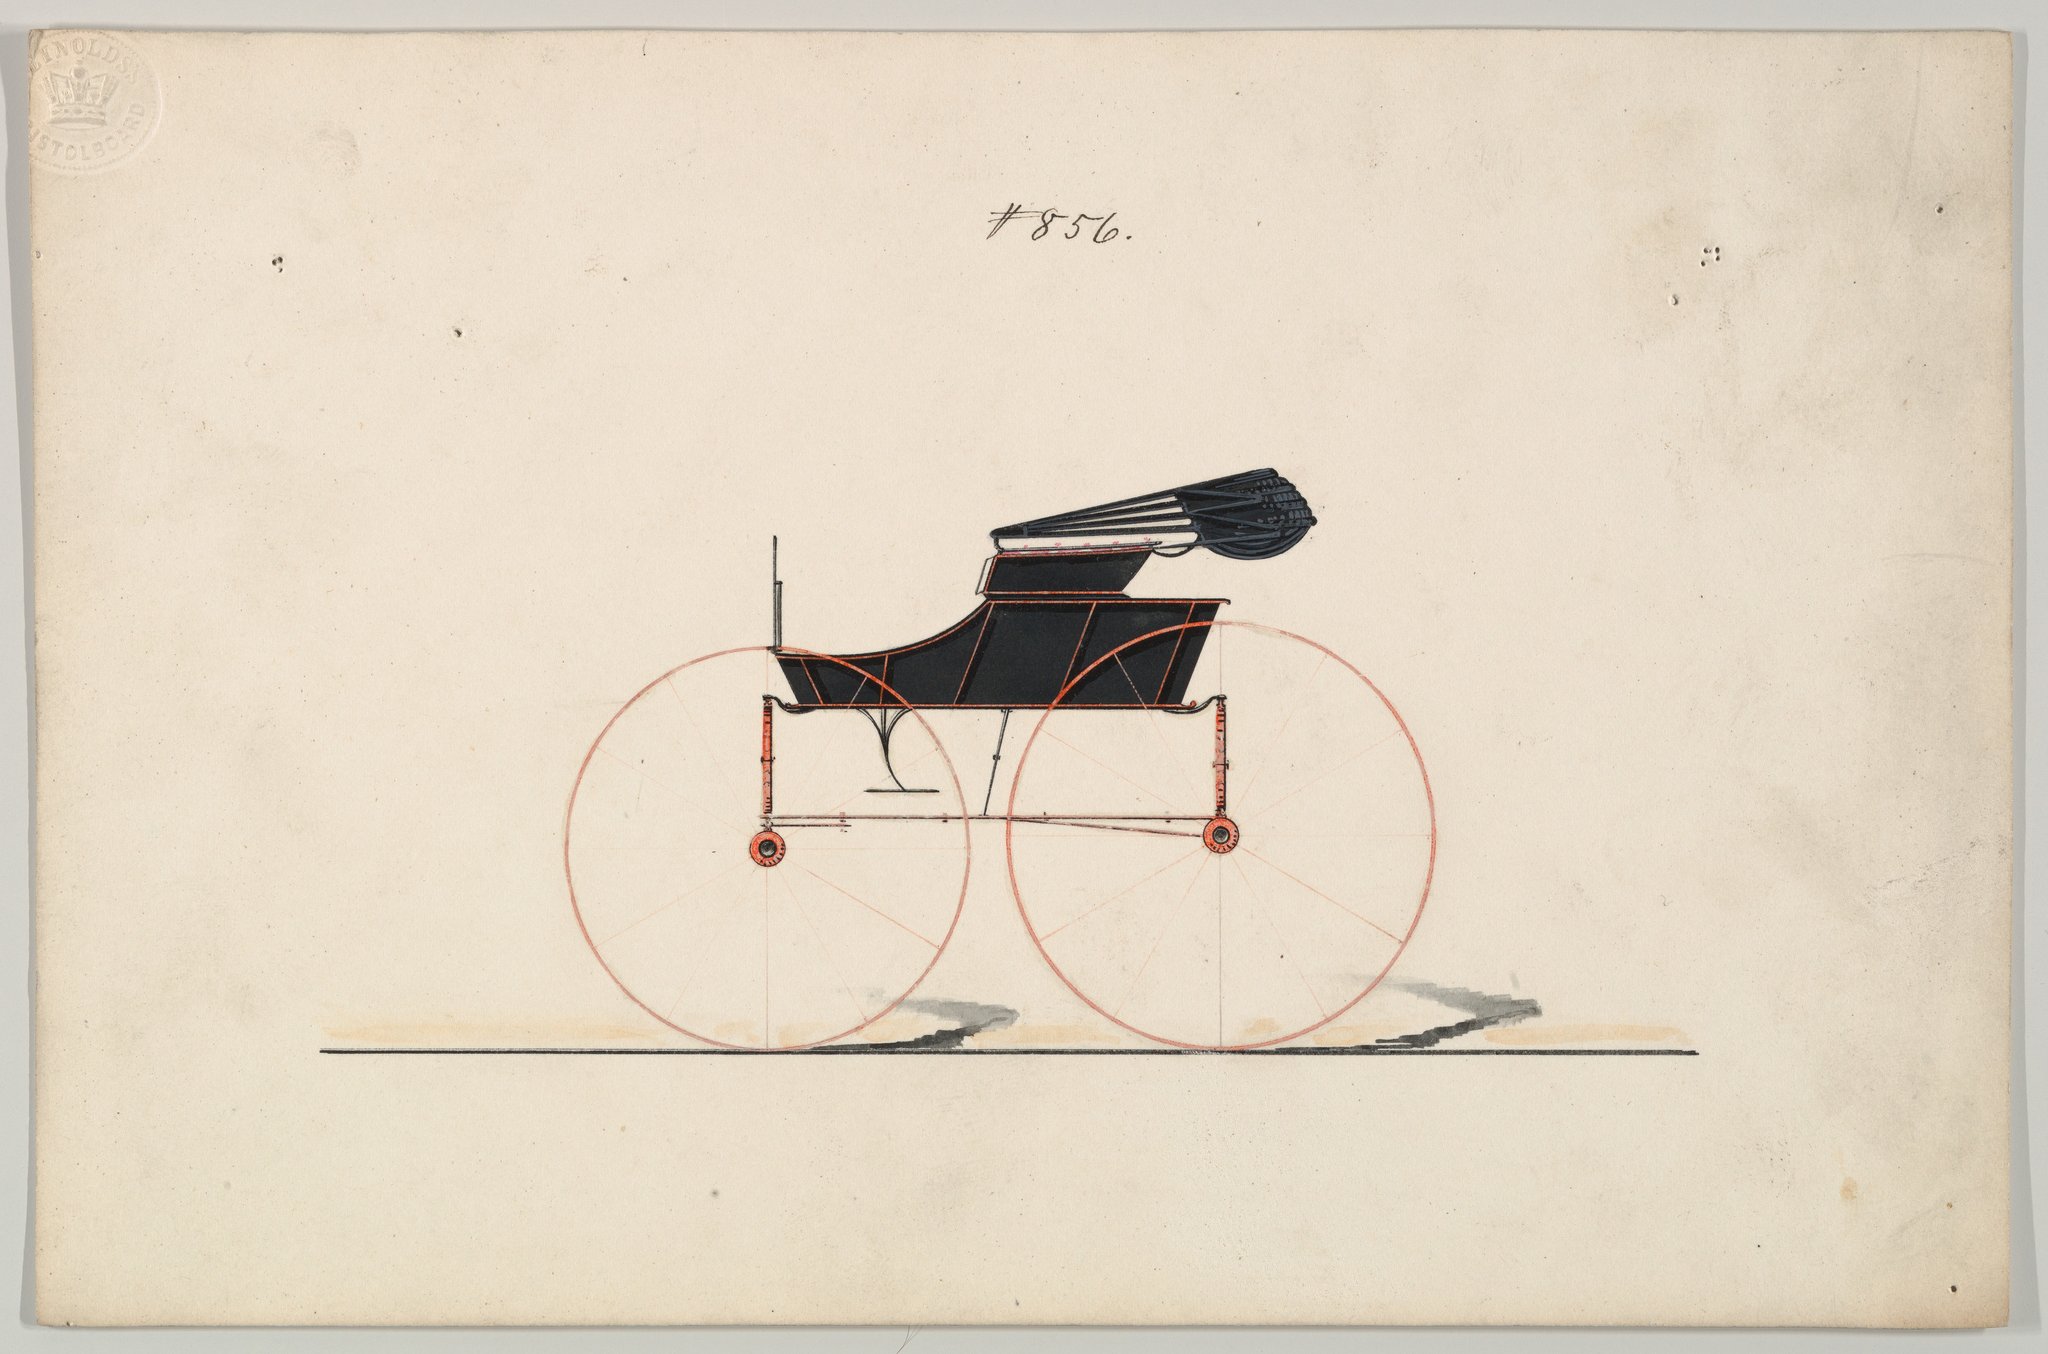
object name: drawing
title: Design for Wagon, no. 856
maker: brewster & co.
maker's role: manufacturer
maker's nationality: american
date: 1860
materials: gouache, ink, watercolor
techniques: pen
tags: carriages